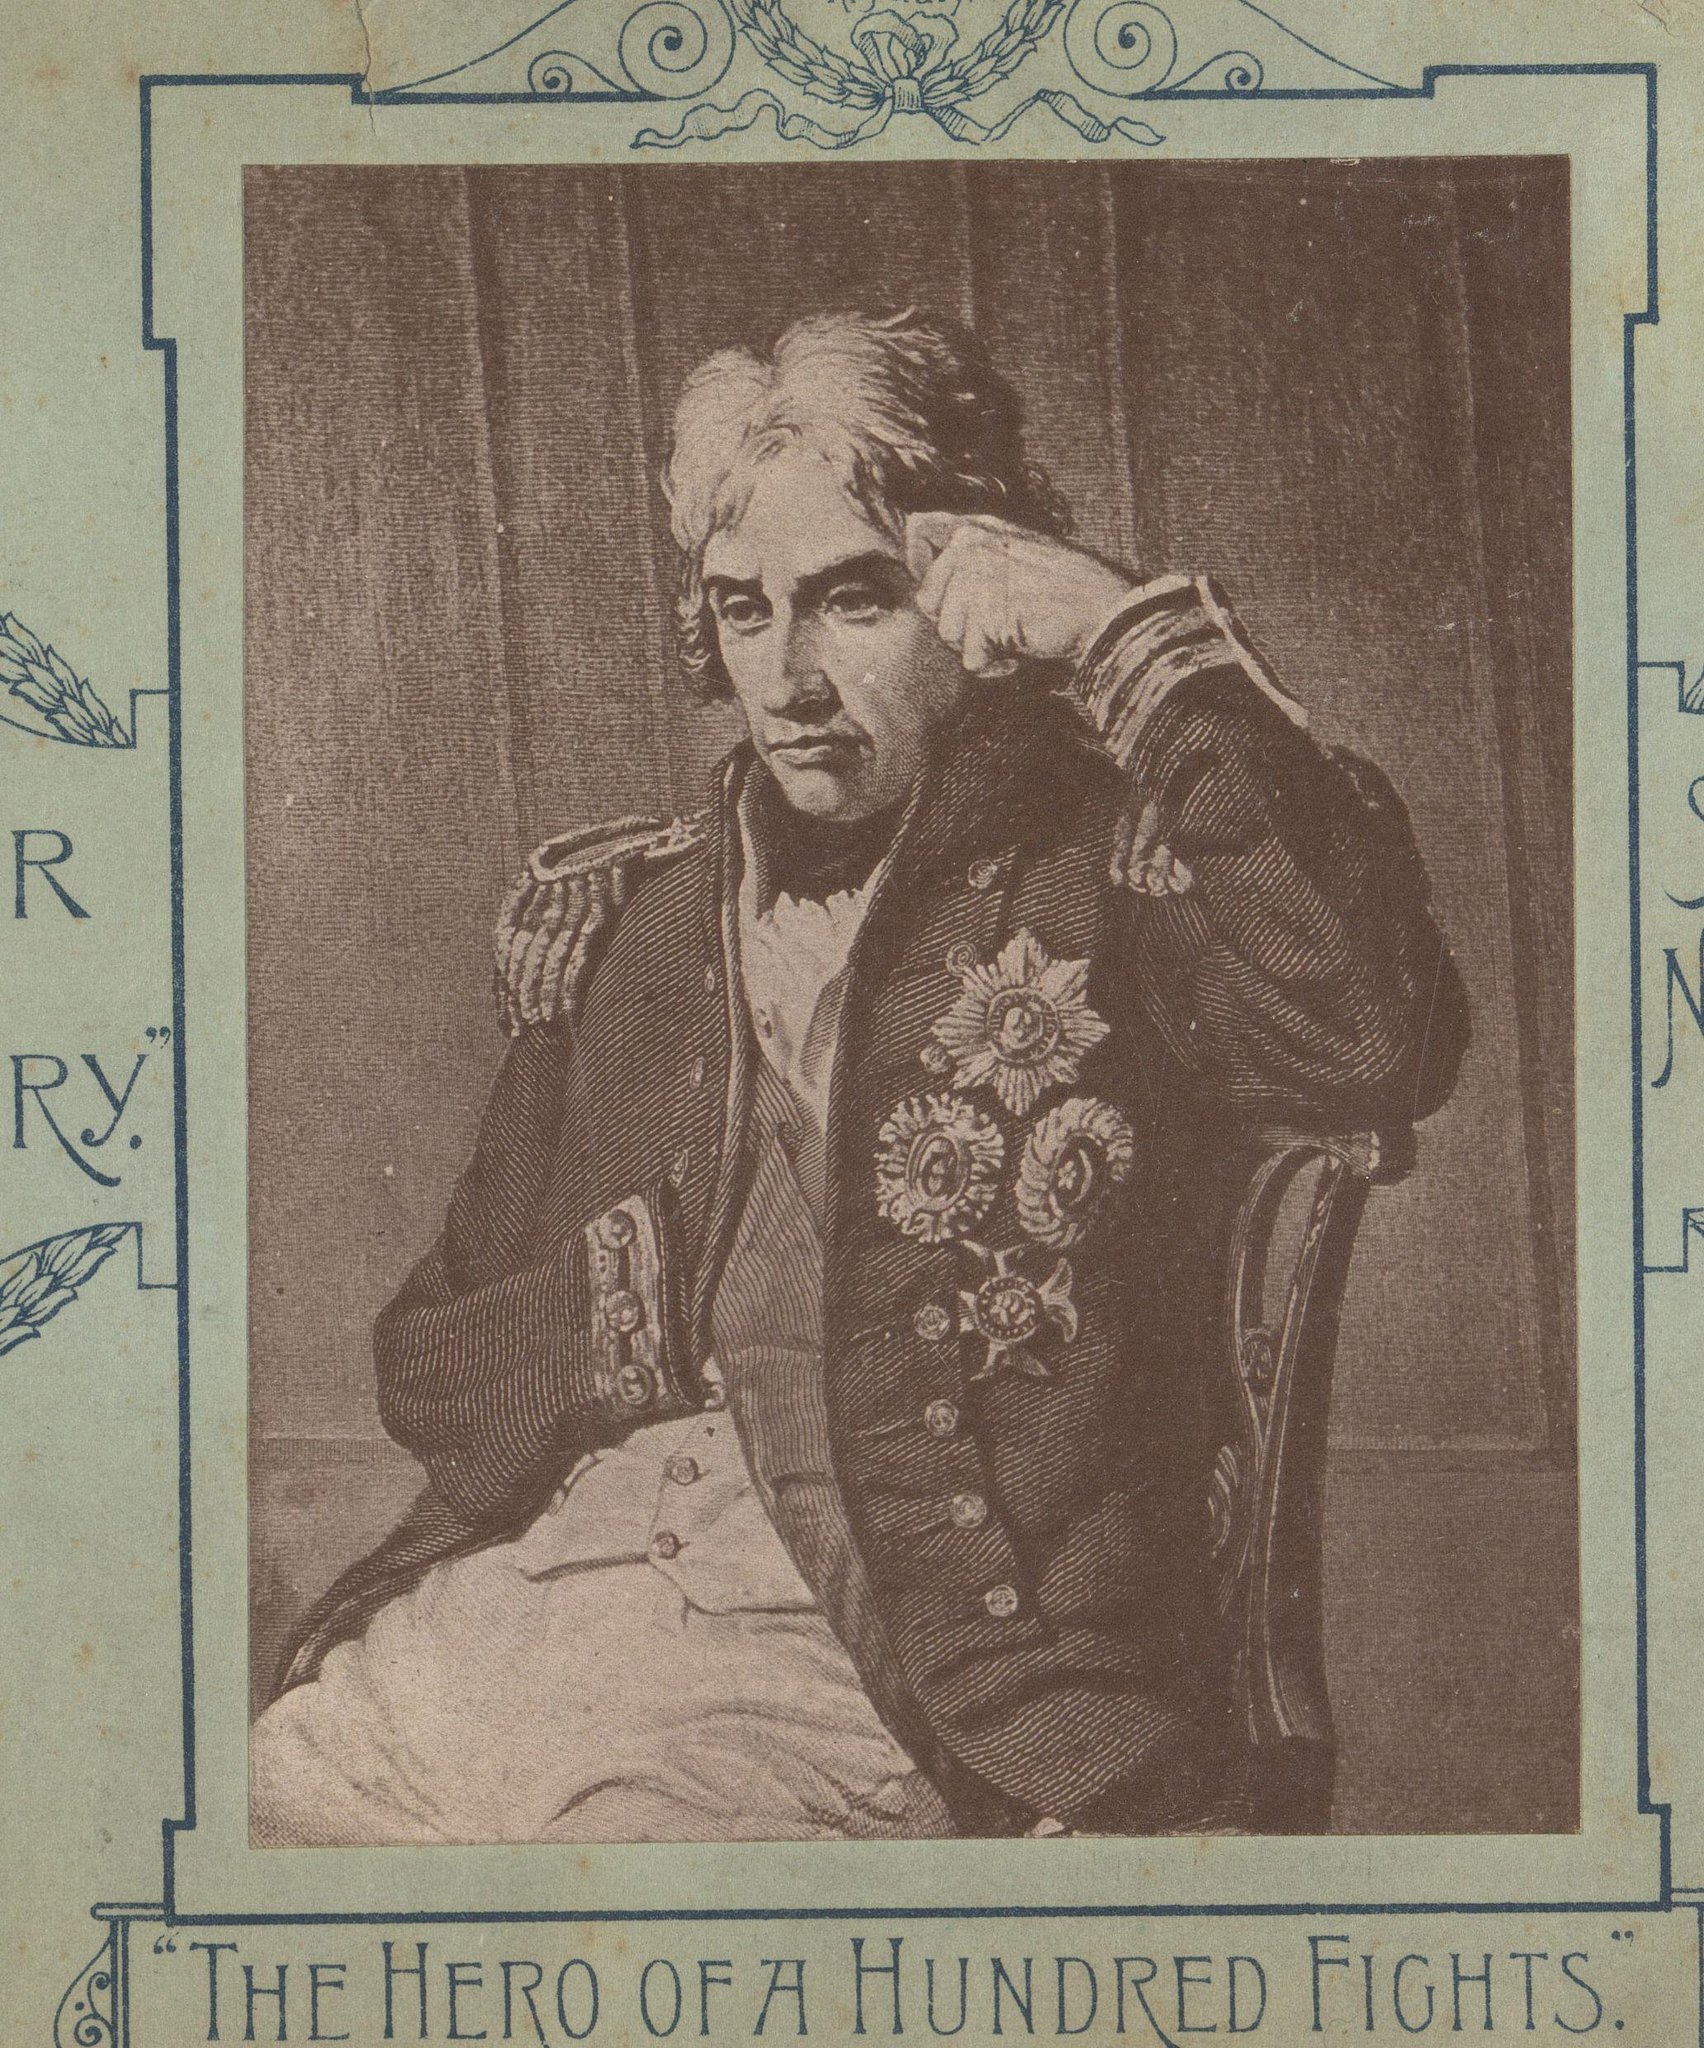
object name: page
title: Fotoreproductie van een schilderij, voorstellende een portret van Horatio Nelson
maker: Anonymous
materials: paper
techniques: photograph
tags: horatio nelson (hertog van bronte), commander-in-chief, admiral